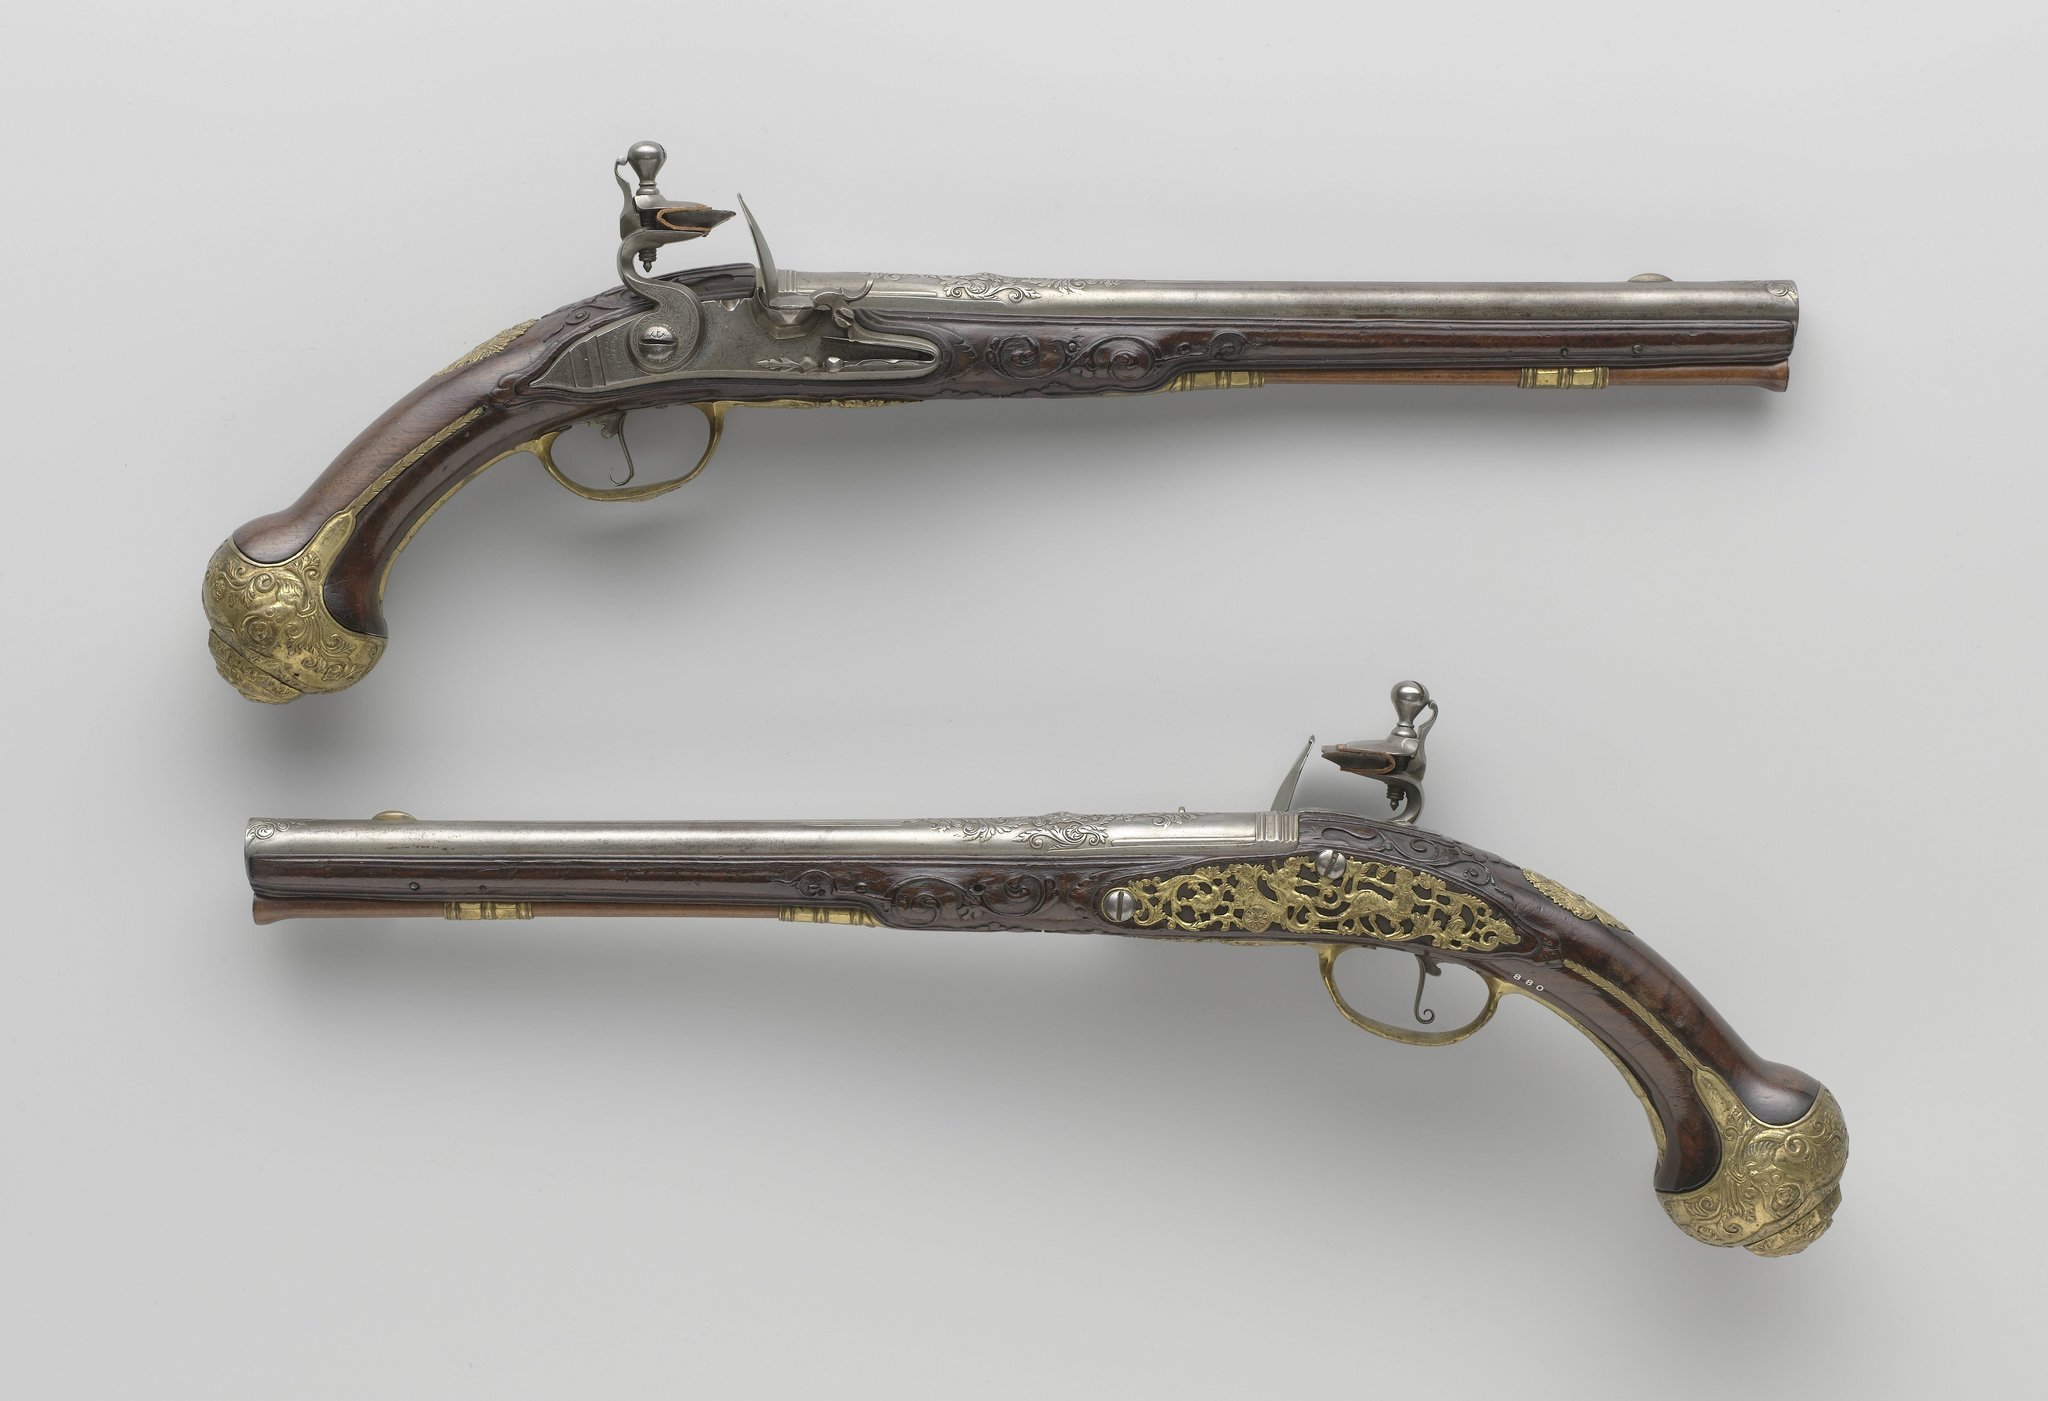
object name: flintlock pistol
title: Vuursteenpistool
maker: wernand droogbrood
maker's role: geweermaker, lademaker, pistoolmaker, smid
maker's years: -1751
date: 1710-1720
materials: brass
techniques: printing, casting, metalworking, cutting, embroidery, engraving, gilding, relief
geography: utrecht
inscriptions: signature: ‘W DROOGBROOD // UTRECHT’, mark: ‘stadskeur van Utrecht’